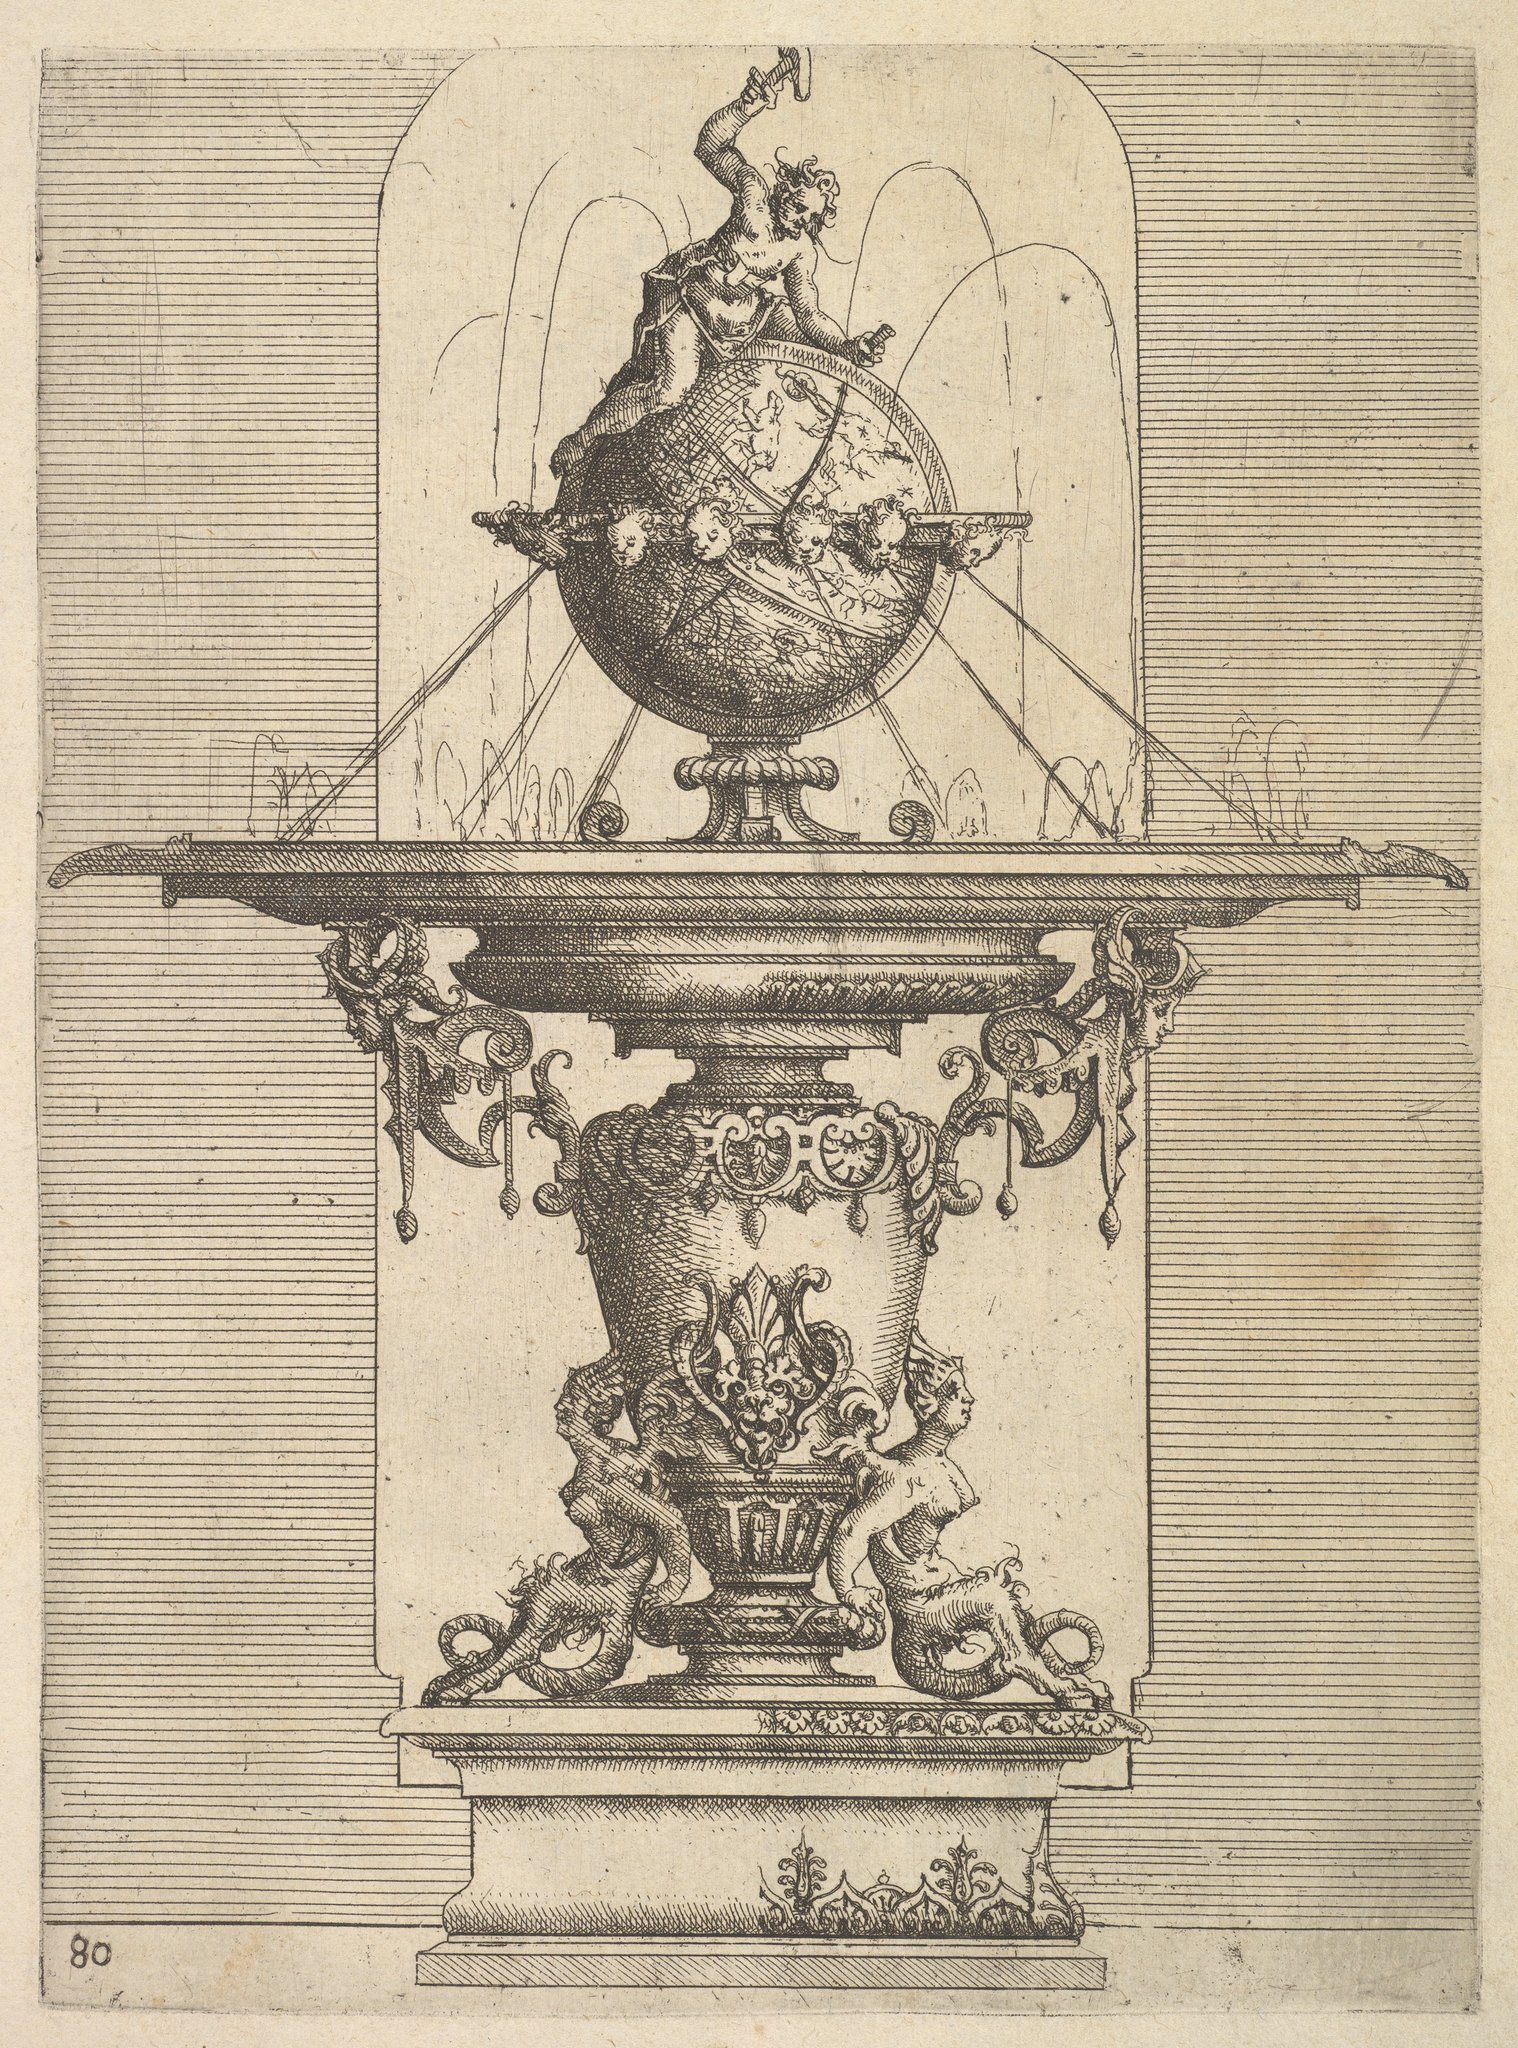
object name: print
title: Design for a Fountain, plate 80 from "Architettura"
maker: wendel dietterlin, the elder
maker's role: artist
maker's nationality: german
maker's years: 1550-1559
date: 1598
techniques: etching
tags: fountains,palmettes,globes